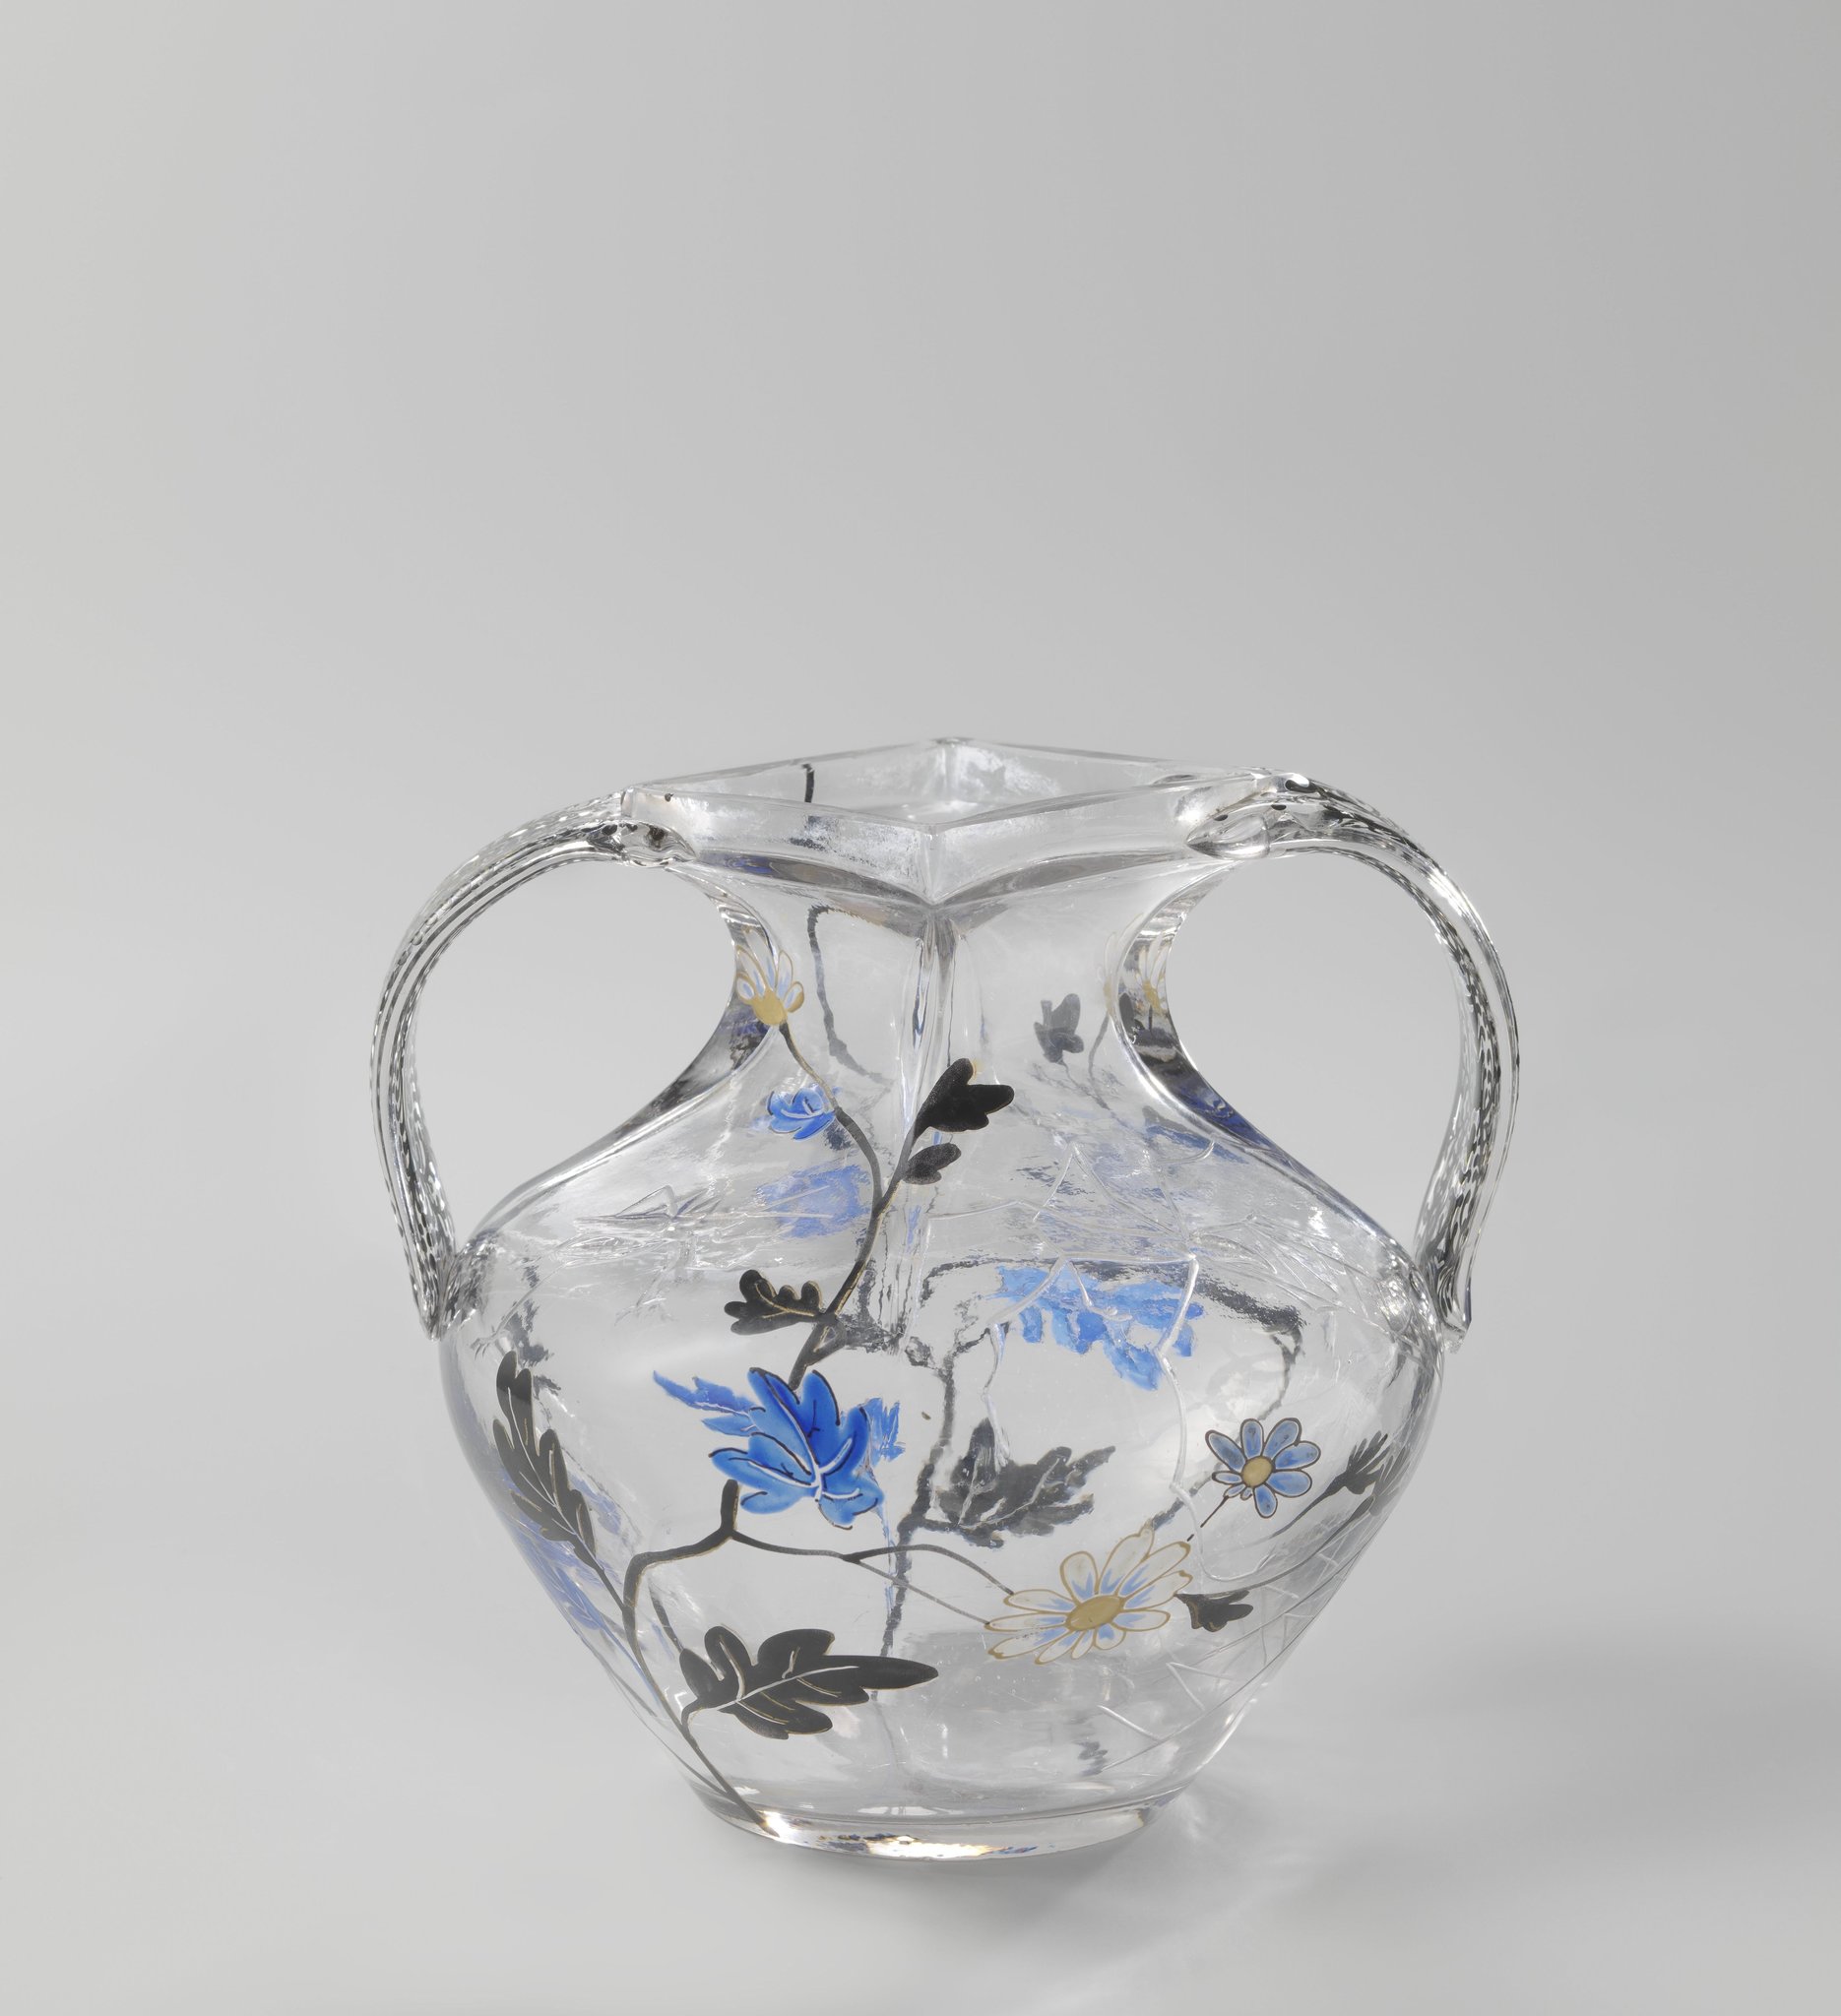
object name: vase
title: Vaas met een krekel, een spin, een sprinkhaan en een libel tussen bloem- en bladranken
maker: émile gallé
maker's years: 1846-1904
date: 1884-1889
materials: glass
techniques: glassblowing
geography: nancy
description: Vase. Glass. Nancy, c. 1884 - 1889, by Emile Gallé.